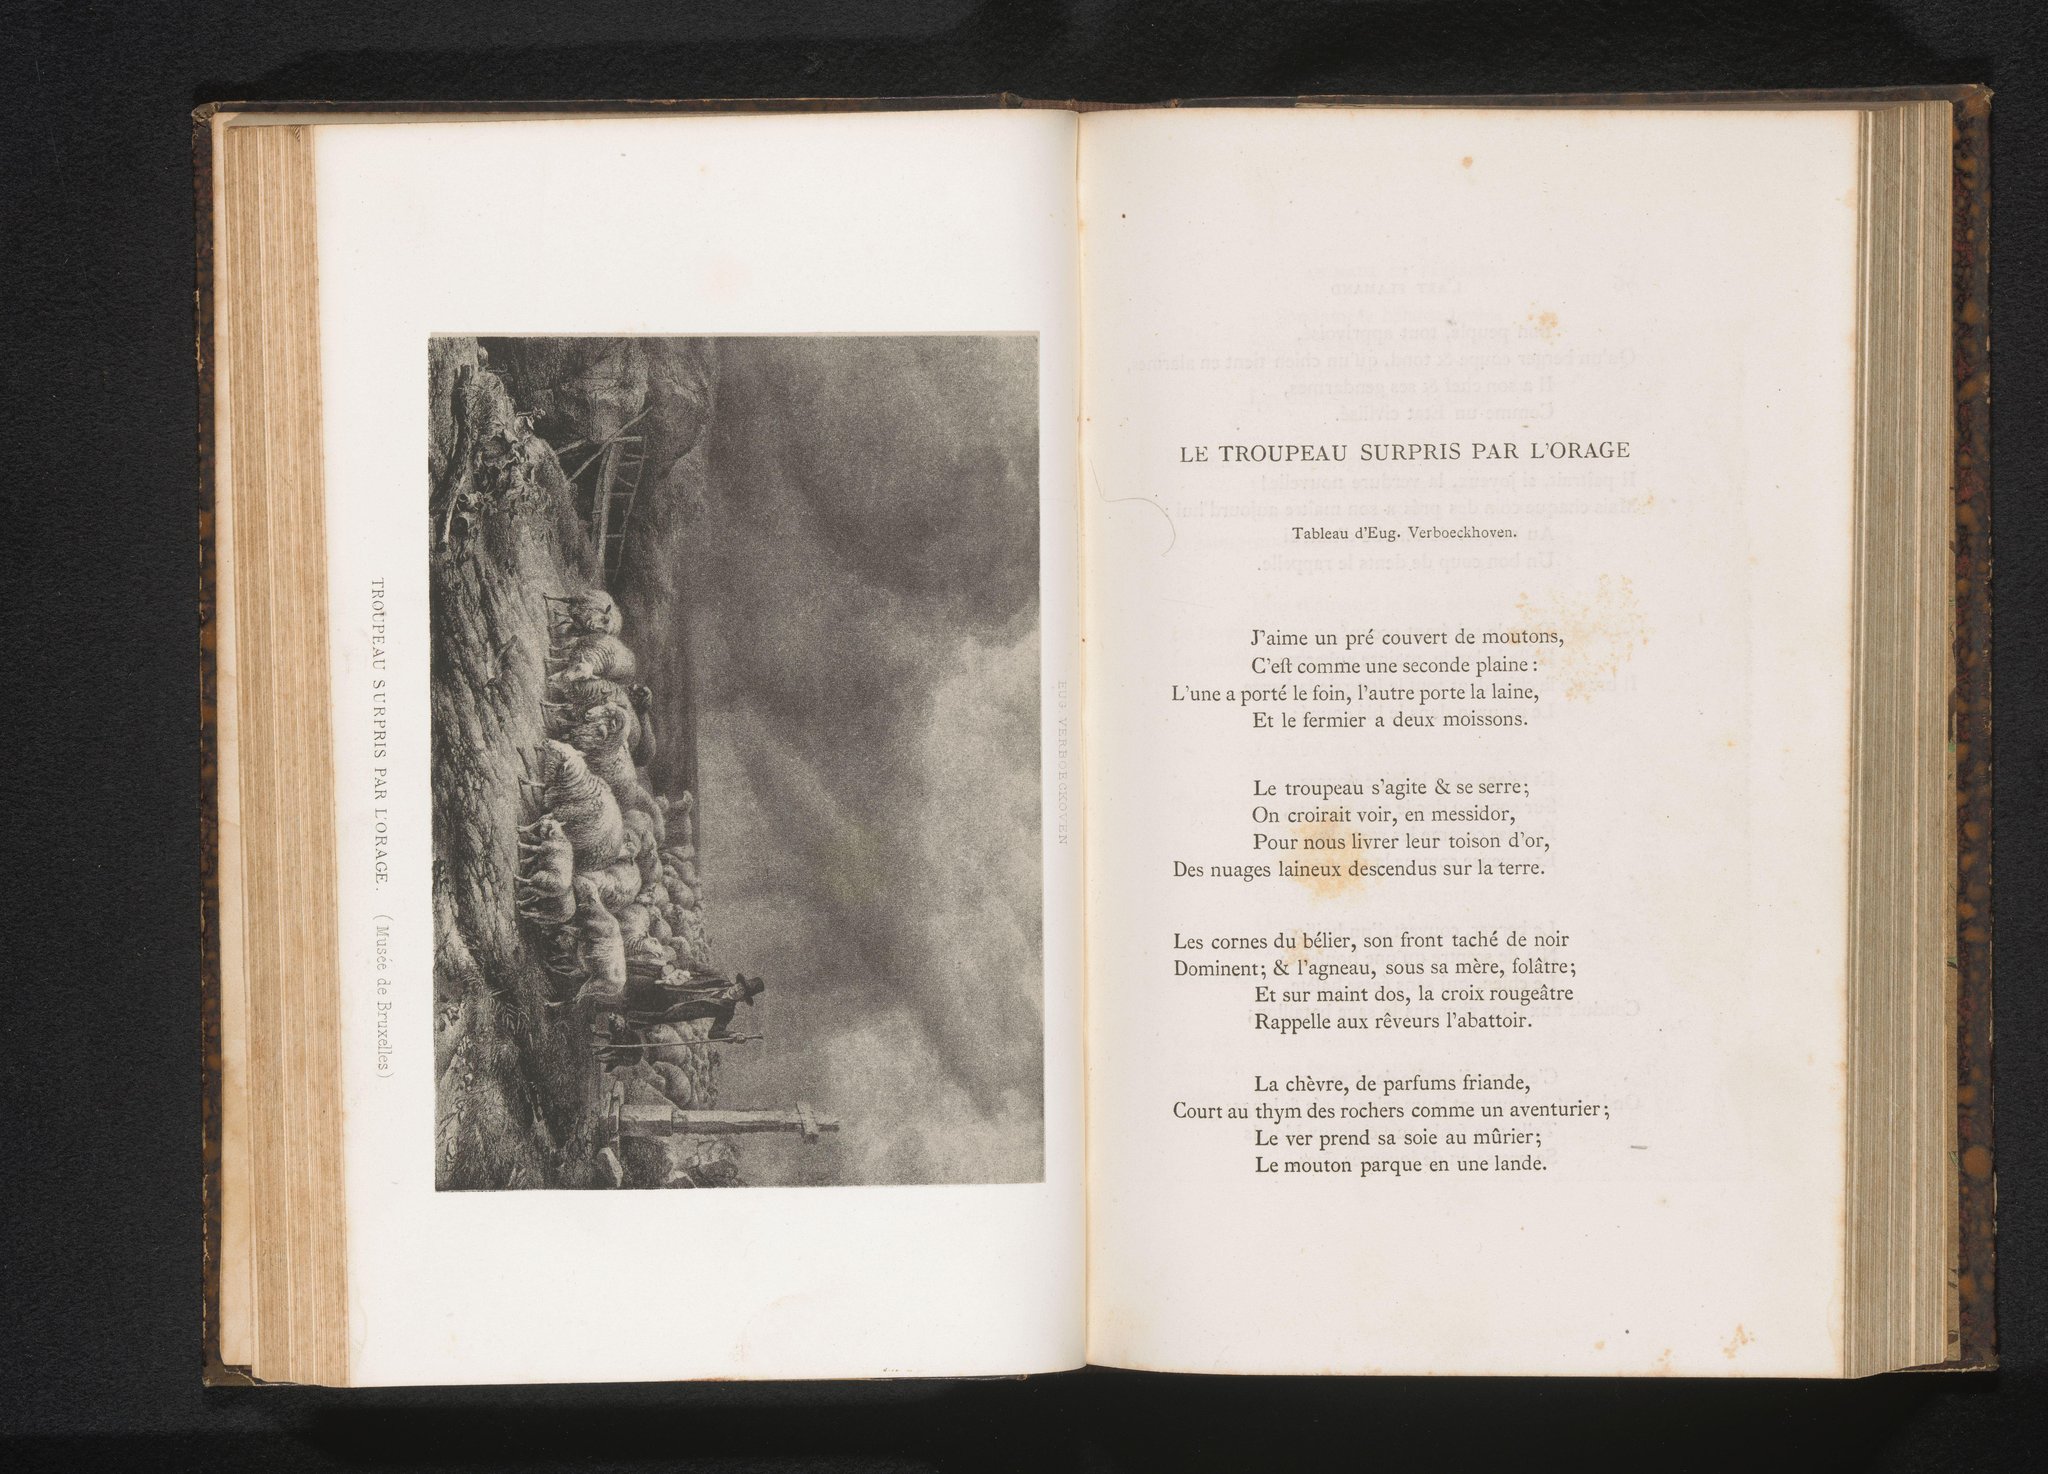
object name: page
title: Reproductie van Kudde schapen verrast door het onweer door Eugène Joseph Verboeckhoven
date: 1862-1867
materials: paper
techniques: photolithography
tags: herding, herdsman, herdswoman, shepherd, shepherdess, cowherd, etc., sheep, herd, flock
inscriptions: inscription: ‘Musée de Bruxelles’